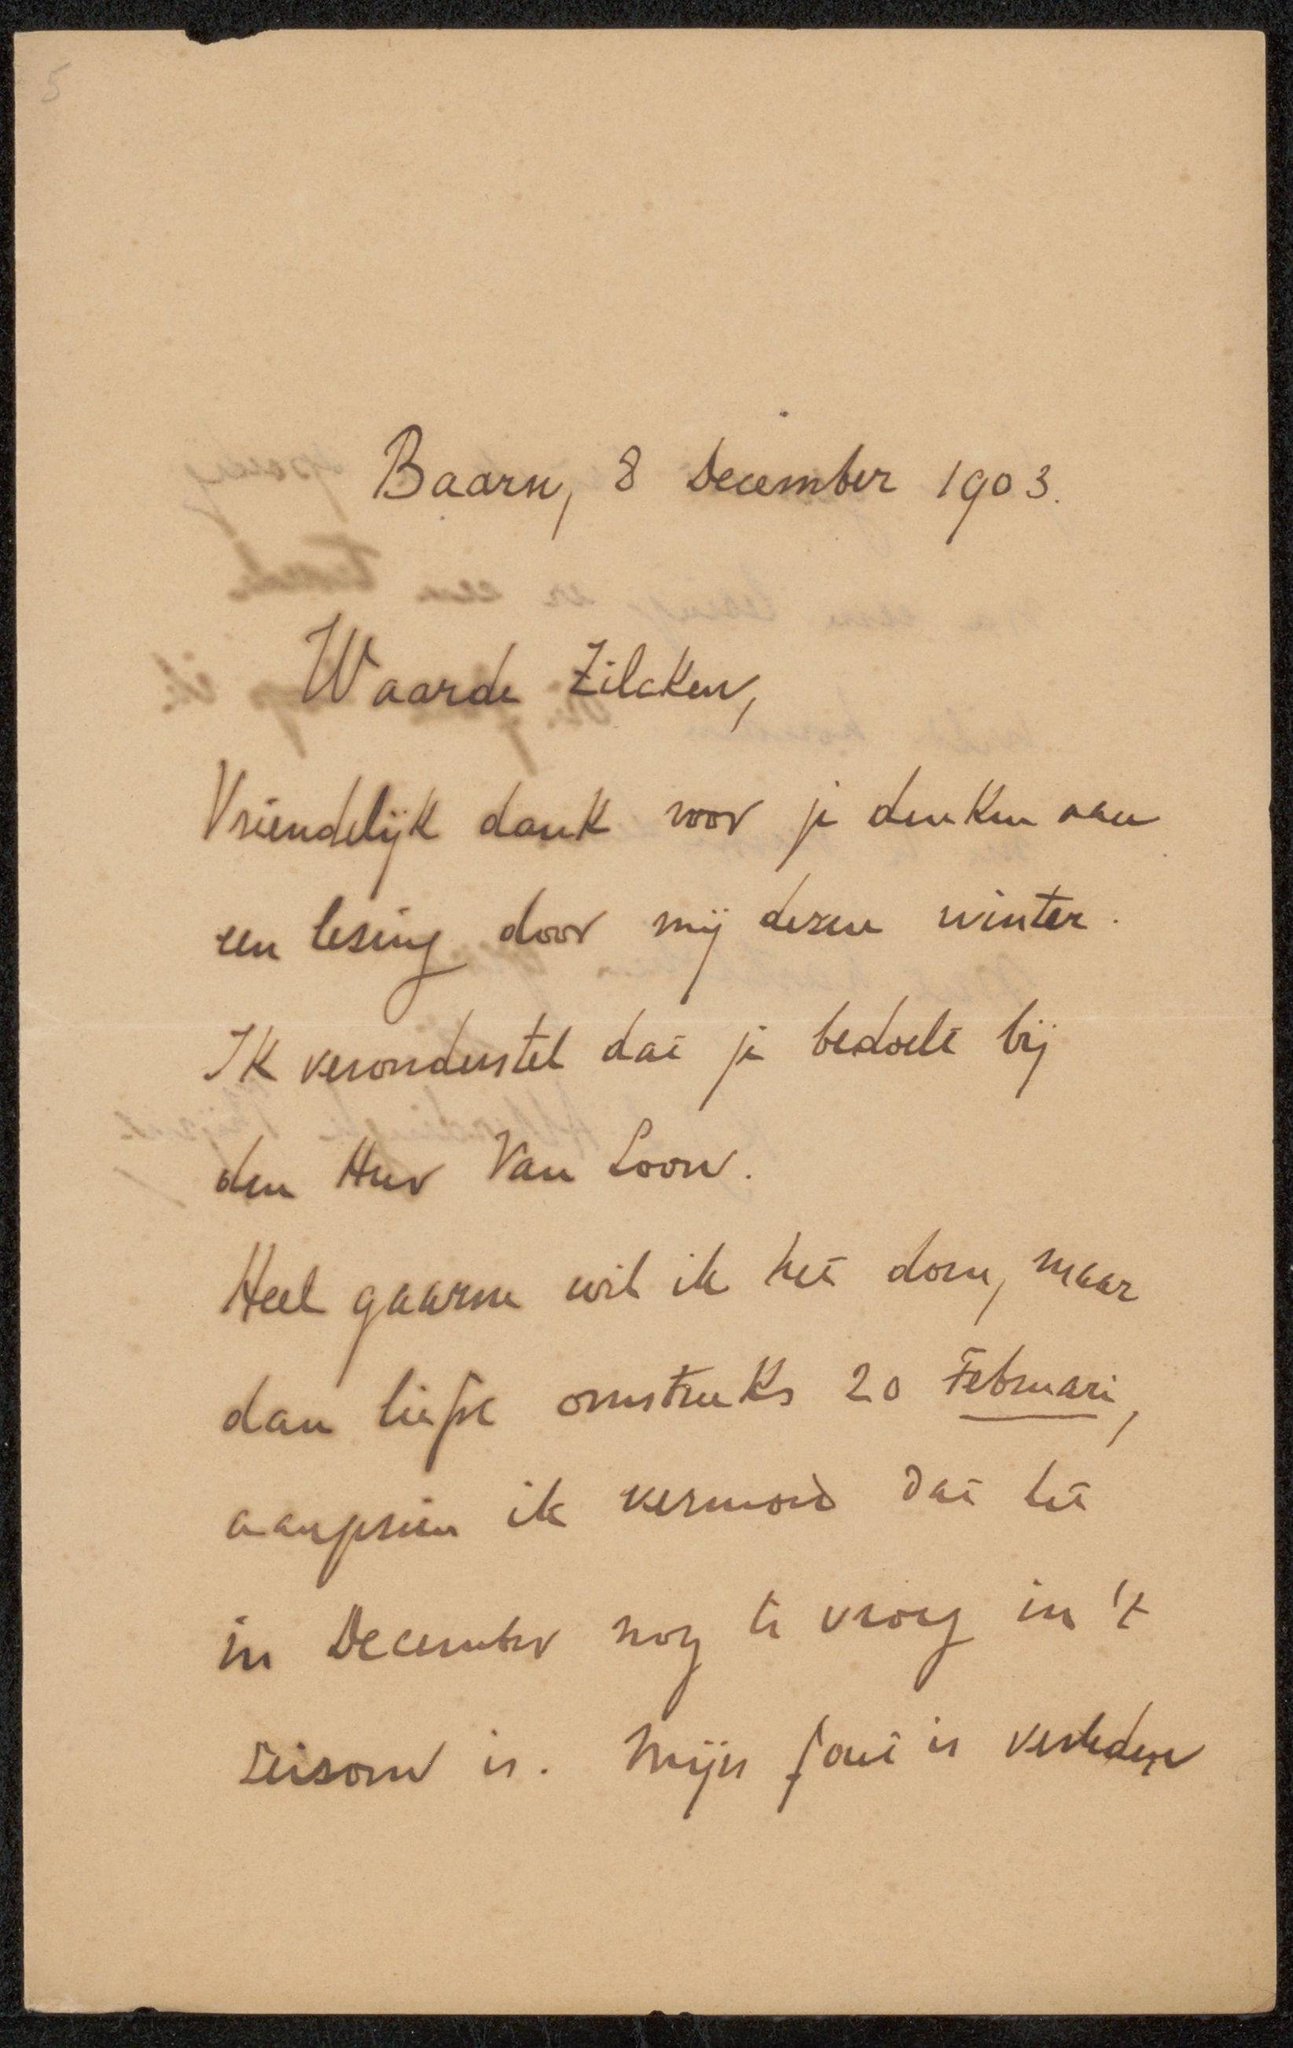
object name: letter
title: Brief aan Philip Zilcken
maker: karel johan lodewijk alberdingk thijm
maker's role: criticus, prozaschrijver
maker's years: 1864-1952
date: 1903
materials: ink, paper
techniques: pen, writing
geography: baarn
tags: ernest van loon, the hague, painter, draughtsman, philip zilcken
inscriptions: collector's mark: ‘RPK’